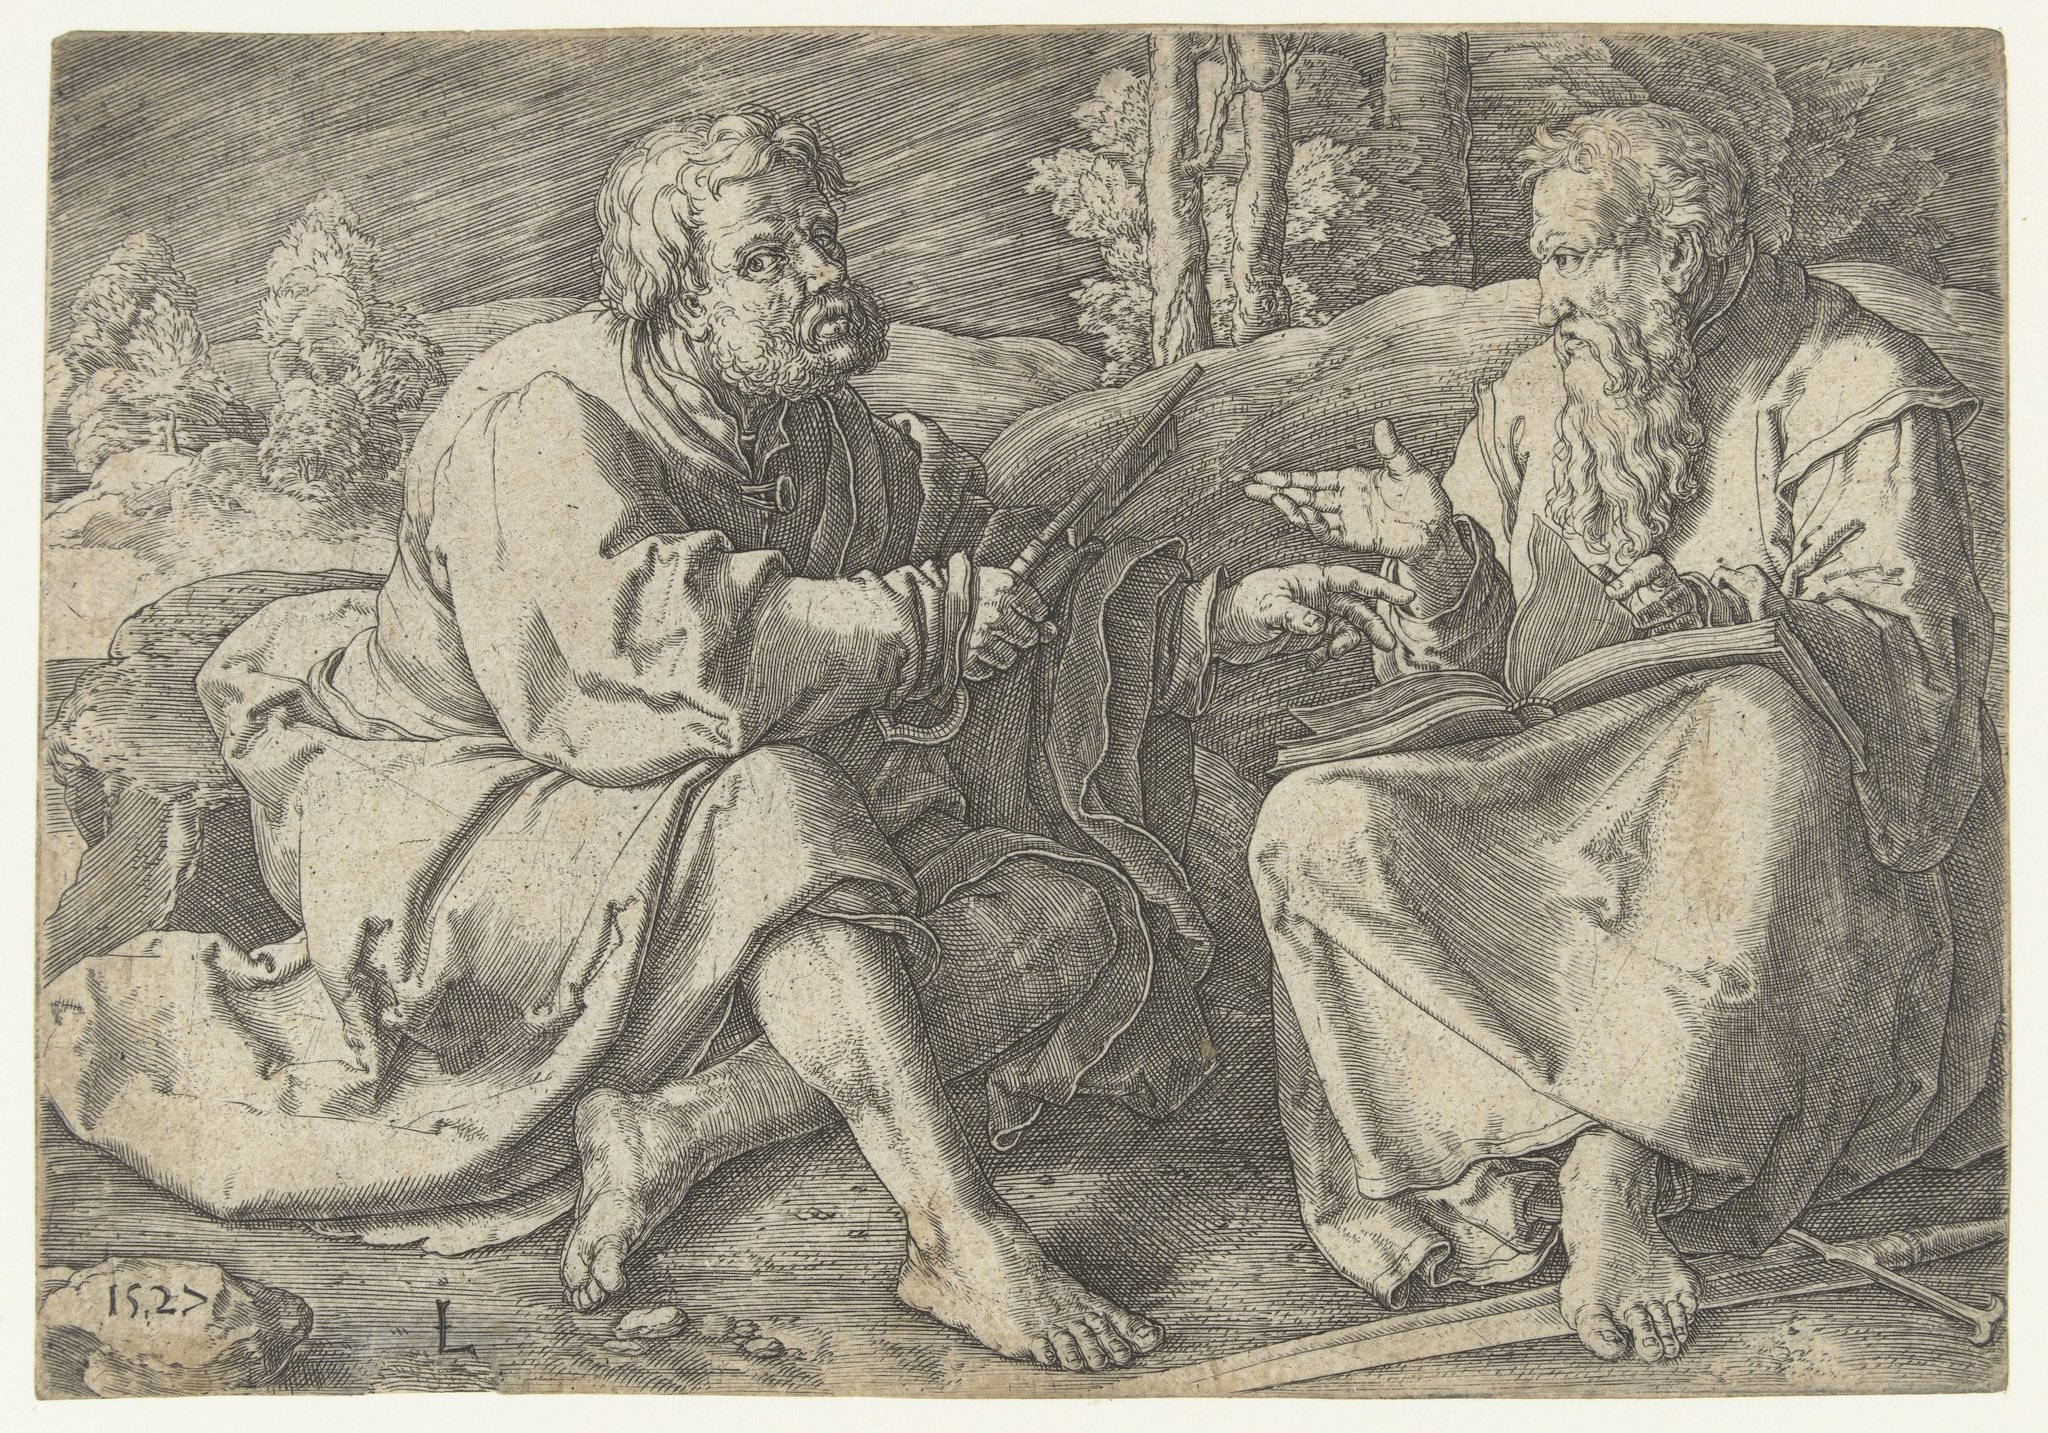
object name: print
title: Paulus en Petrus zittend in een landschap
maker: lucas van leyden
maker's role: draughtsman, painter, print maker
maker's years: 1494-1533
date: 1527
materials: paper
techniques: engraving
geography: low countries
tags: paul and peter disputing in antioch (galatians 2:11-14)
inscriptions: collector's mark: Lugt 11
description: Petrus, met sleutel in hand, in discussie met Paulus met zwaard onder voet en boek op schoot.